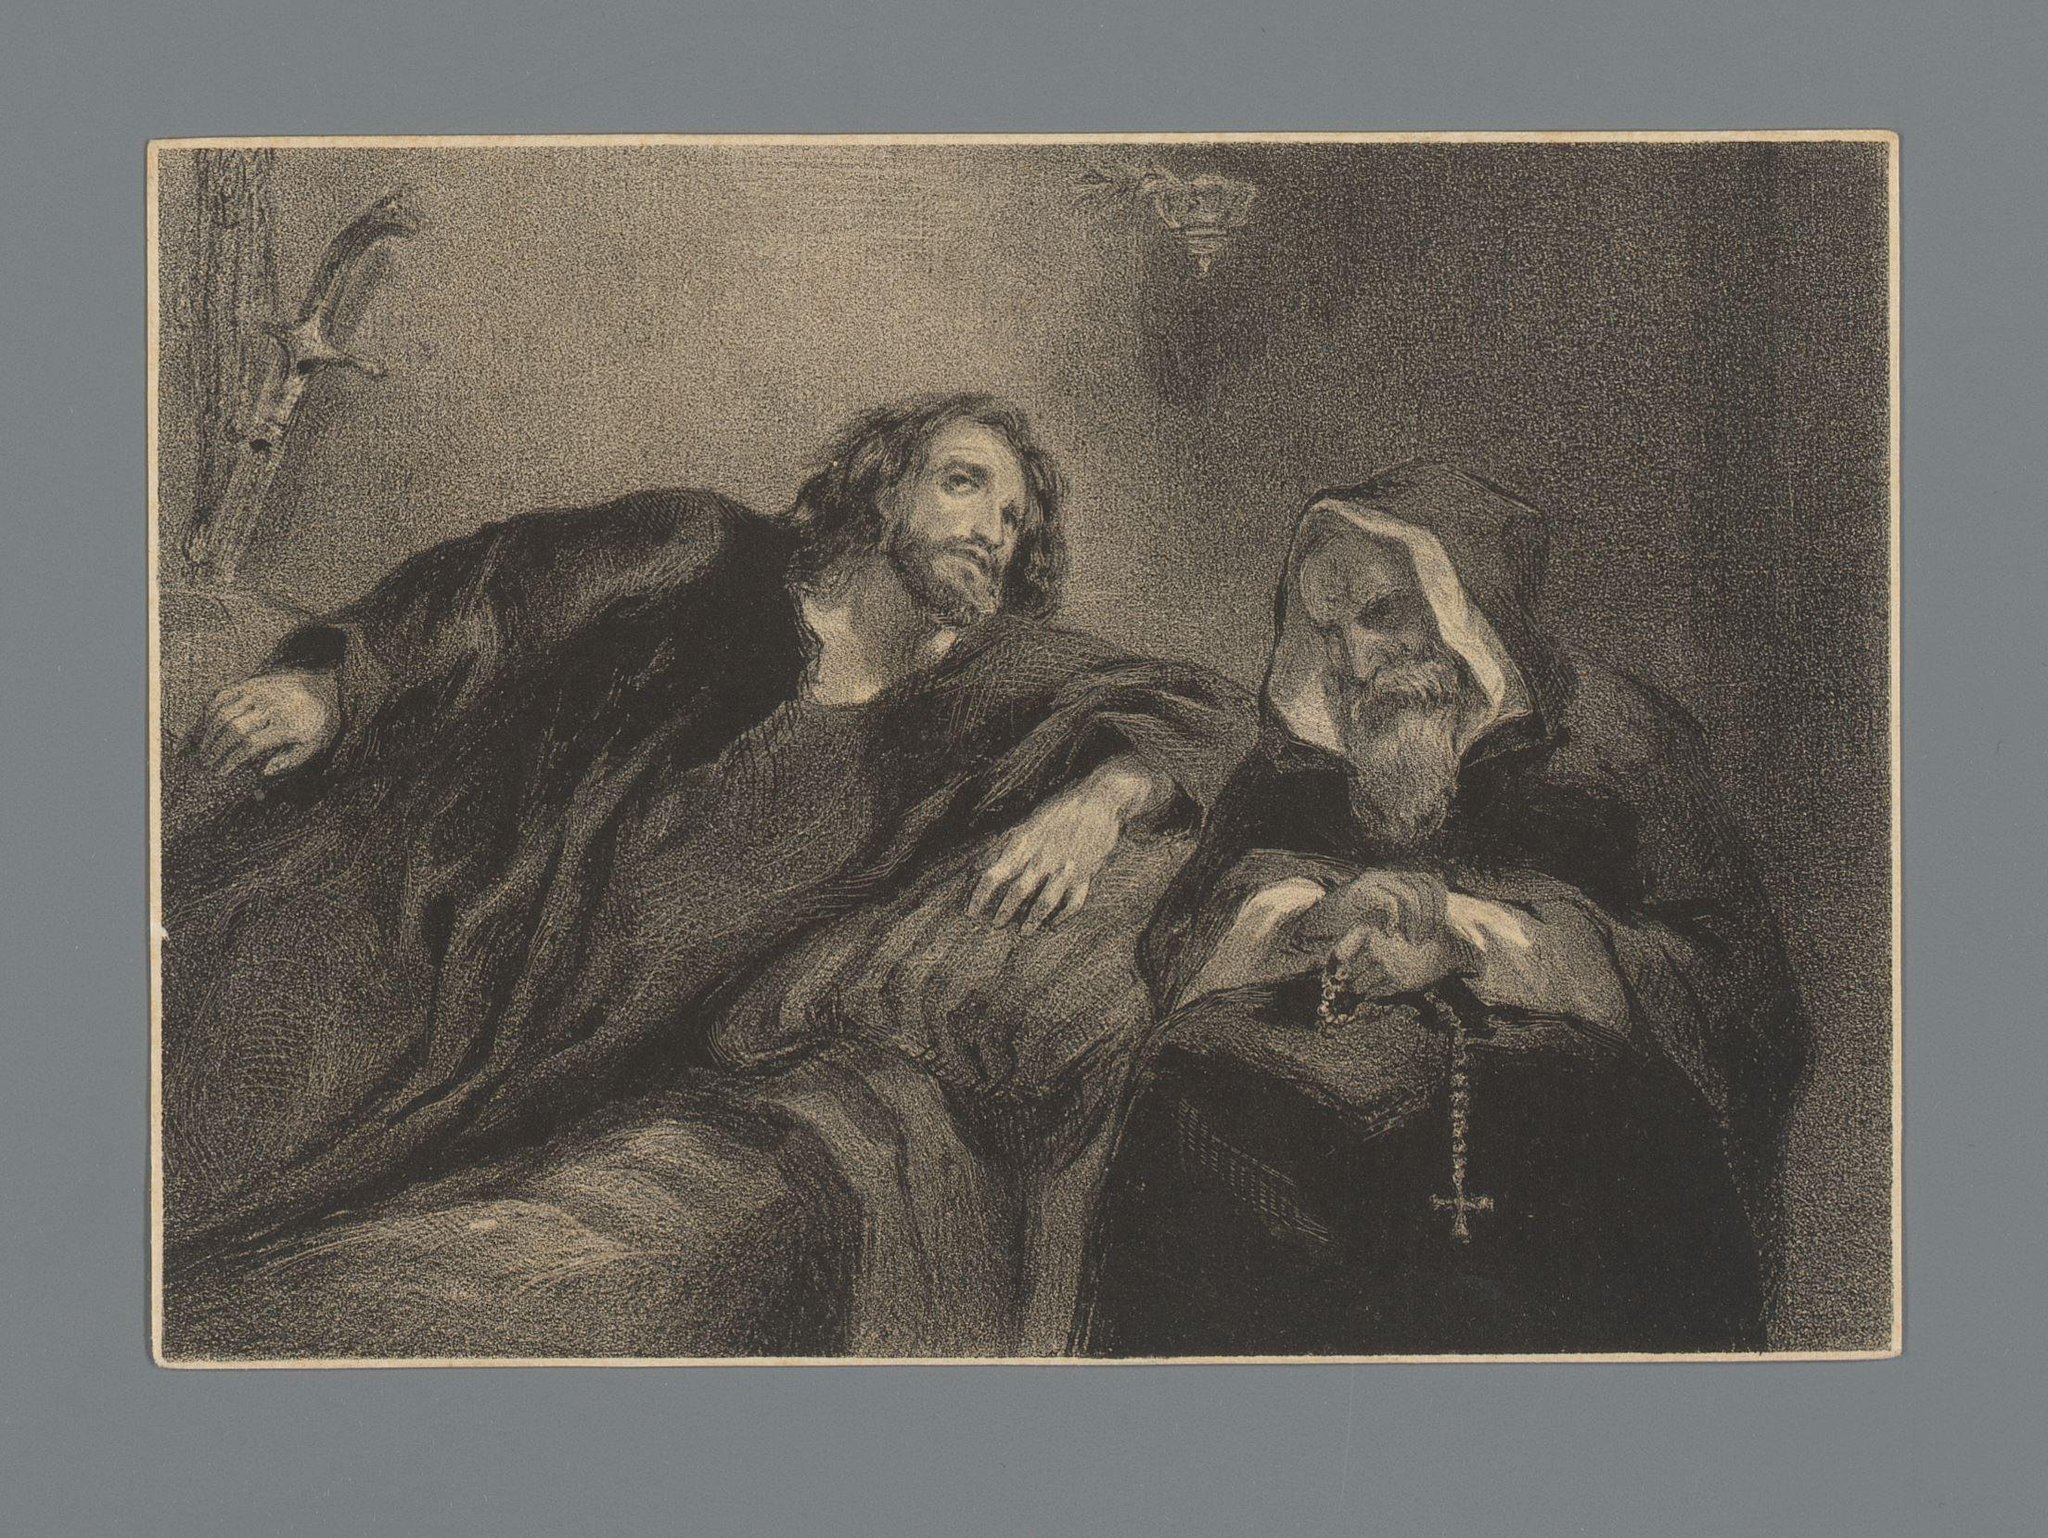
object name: print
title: Man op ligbank naast rooms-katholieke geestelijke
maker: adolphe mouilleron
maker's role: draughtsman, print maker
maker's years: 1820-1881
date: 1830-1881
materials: paper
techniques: lithograph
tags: adult man, confession; 'confessione sacramentale' (ripa) ~ the third of the seven sacraments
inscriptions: collector's mark: Lugt 964, signature: ‘AM’, inscription: ‘TB epreuve’, inscription: ‘Mouilleron d'apr Delacroix/ ep d'essai’